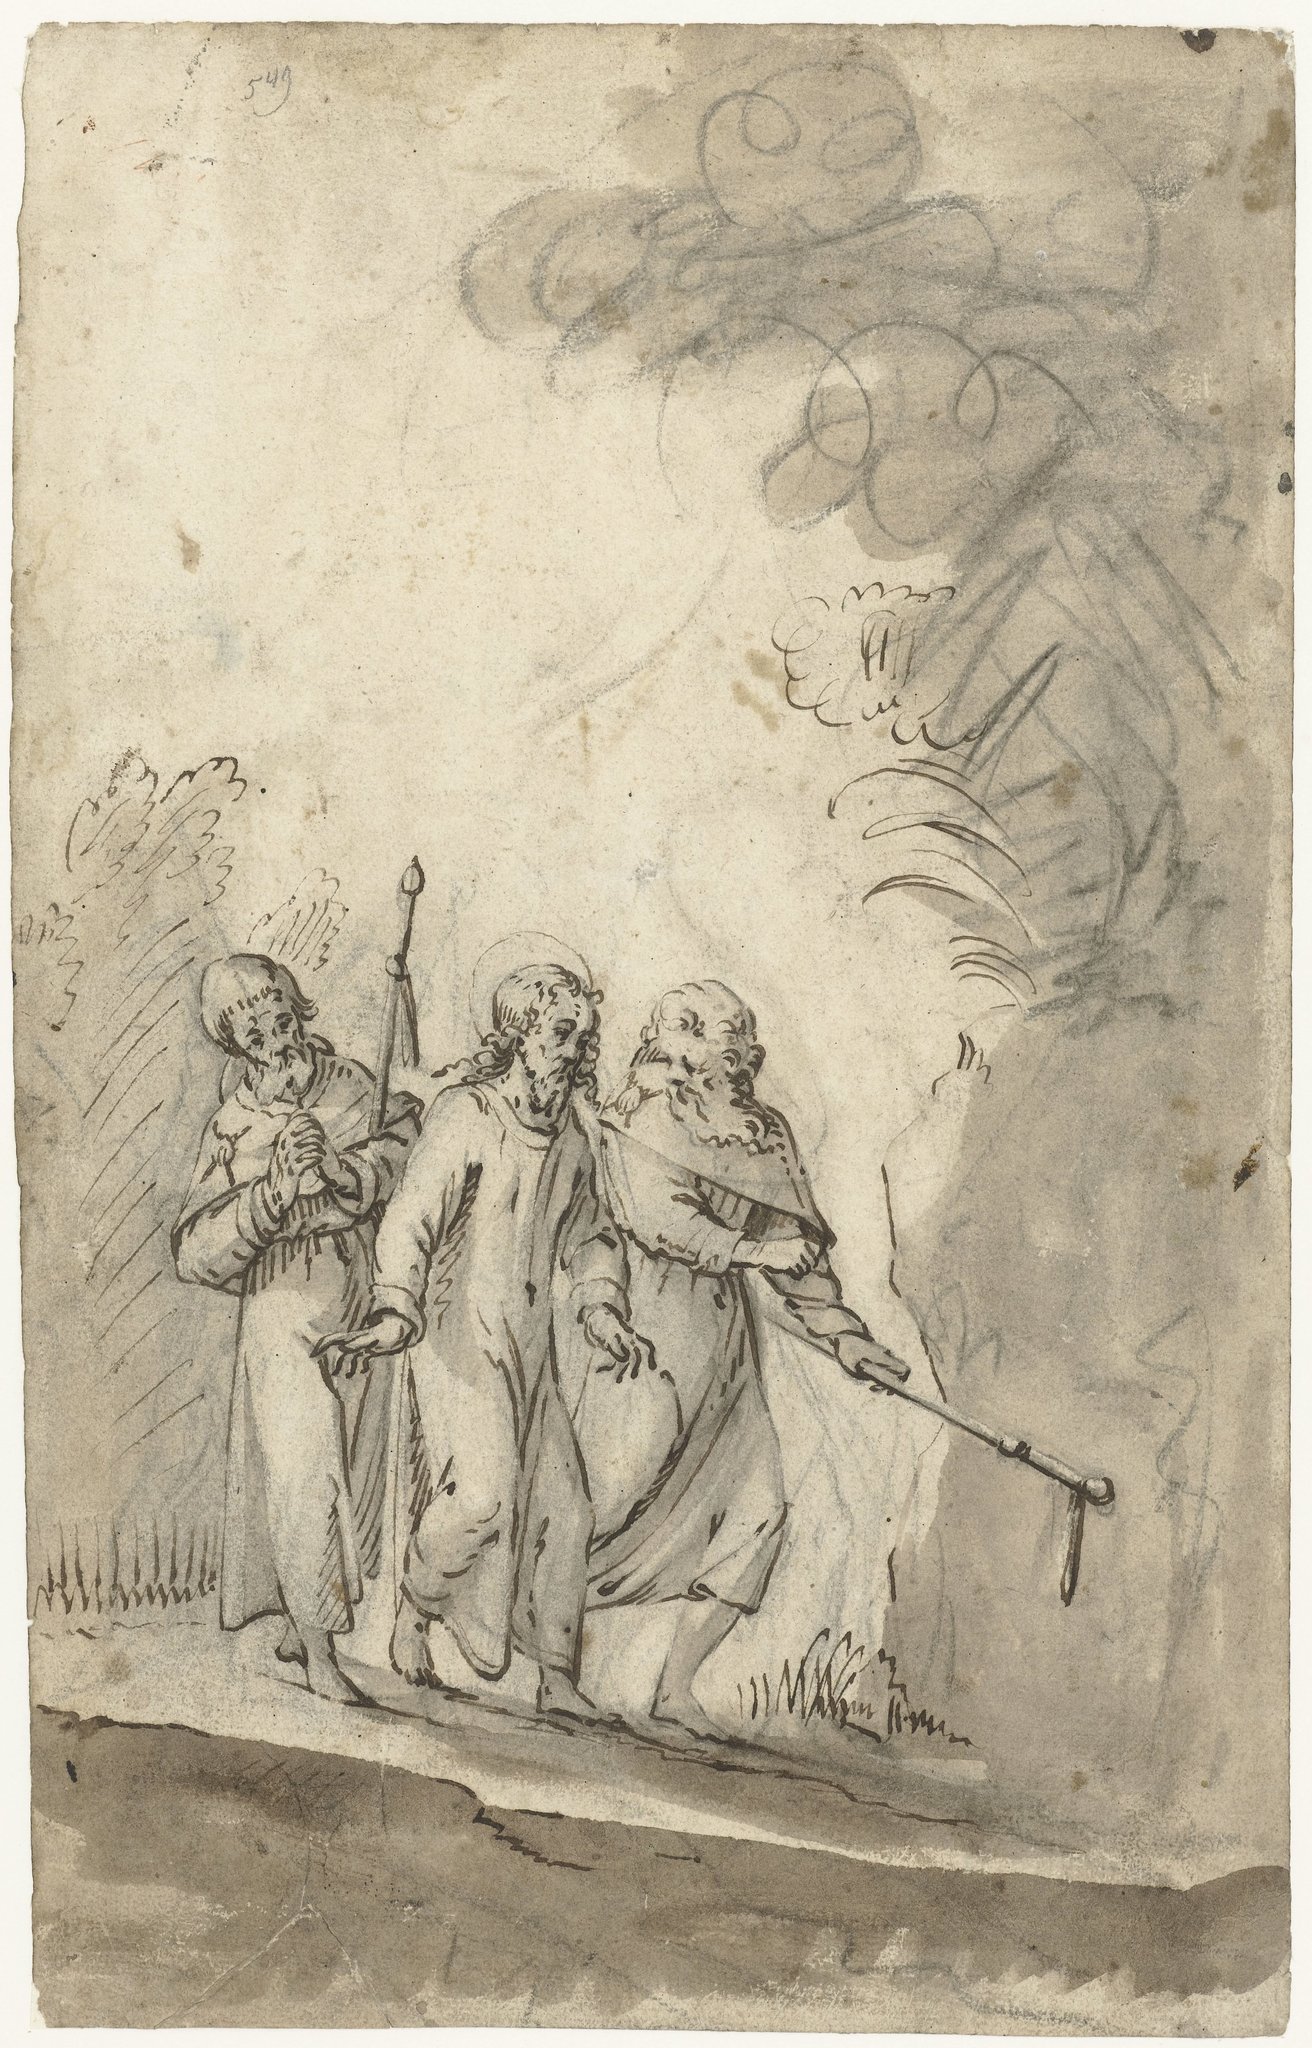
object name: drawing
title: Christus en de discipelen op pad naar Emmaus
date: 1614-1655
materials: chalk, ink, paper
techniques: brush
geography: zwolle